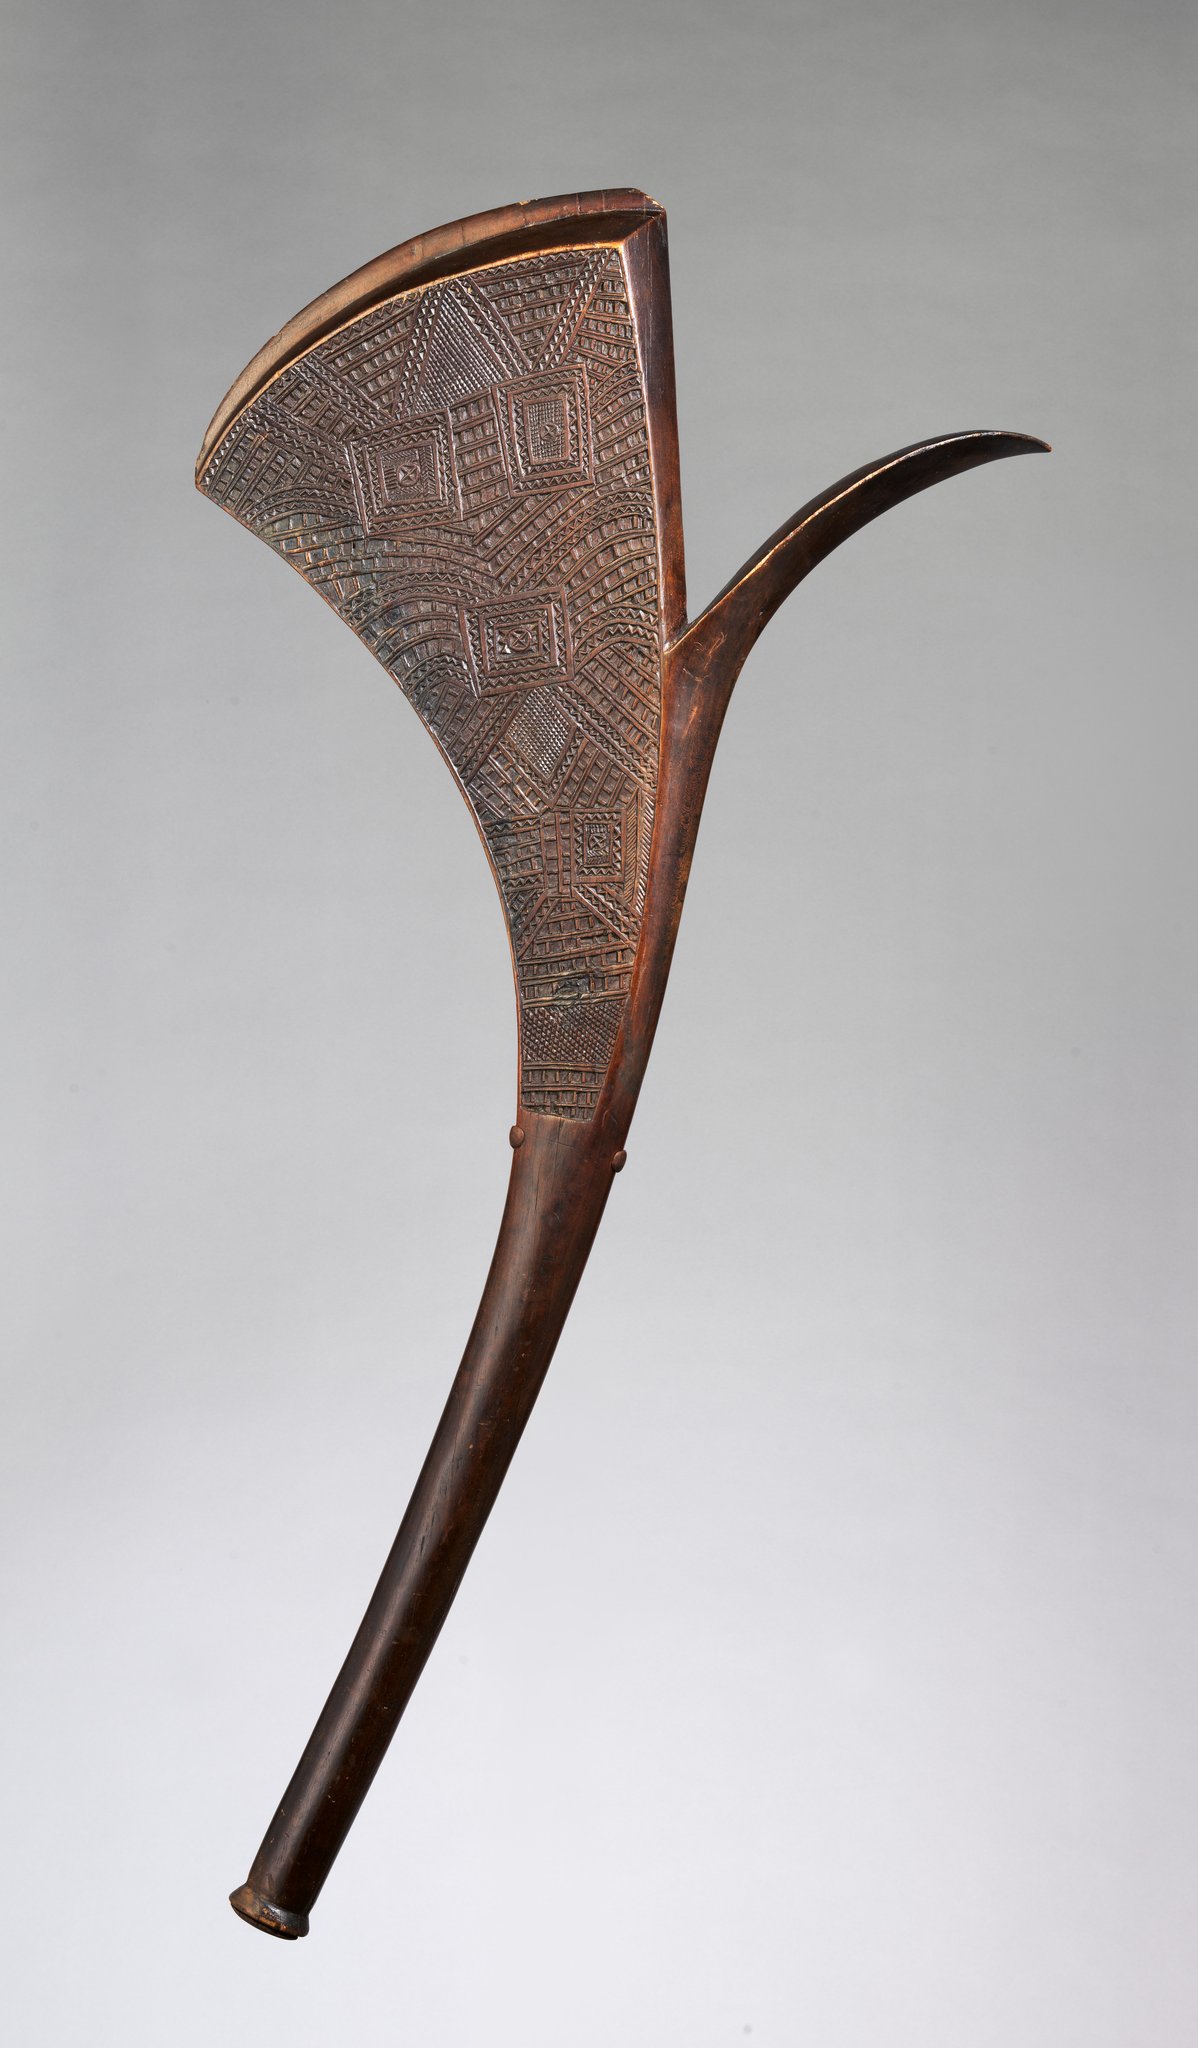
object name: club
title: Club (Sali)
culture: fijian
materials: wood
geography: fiji